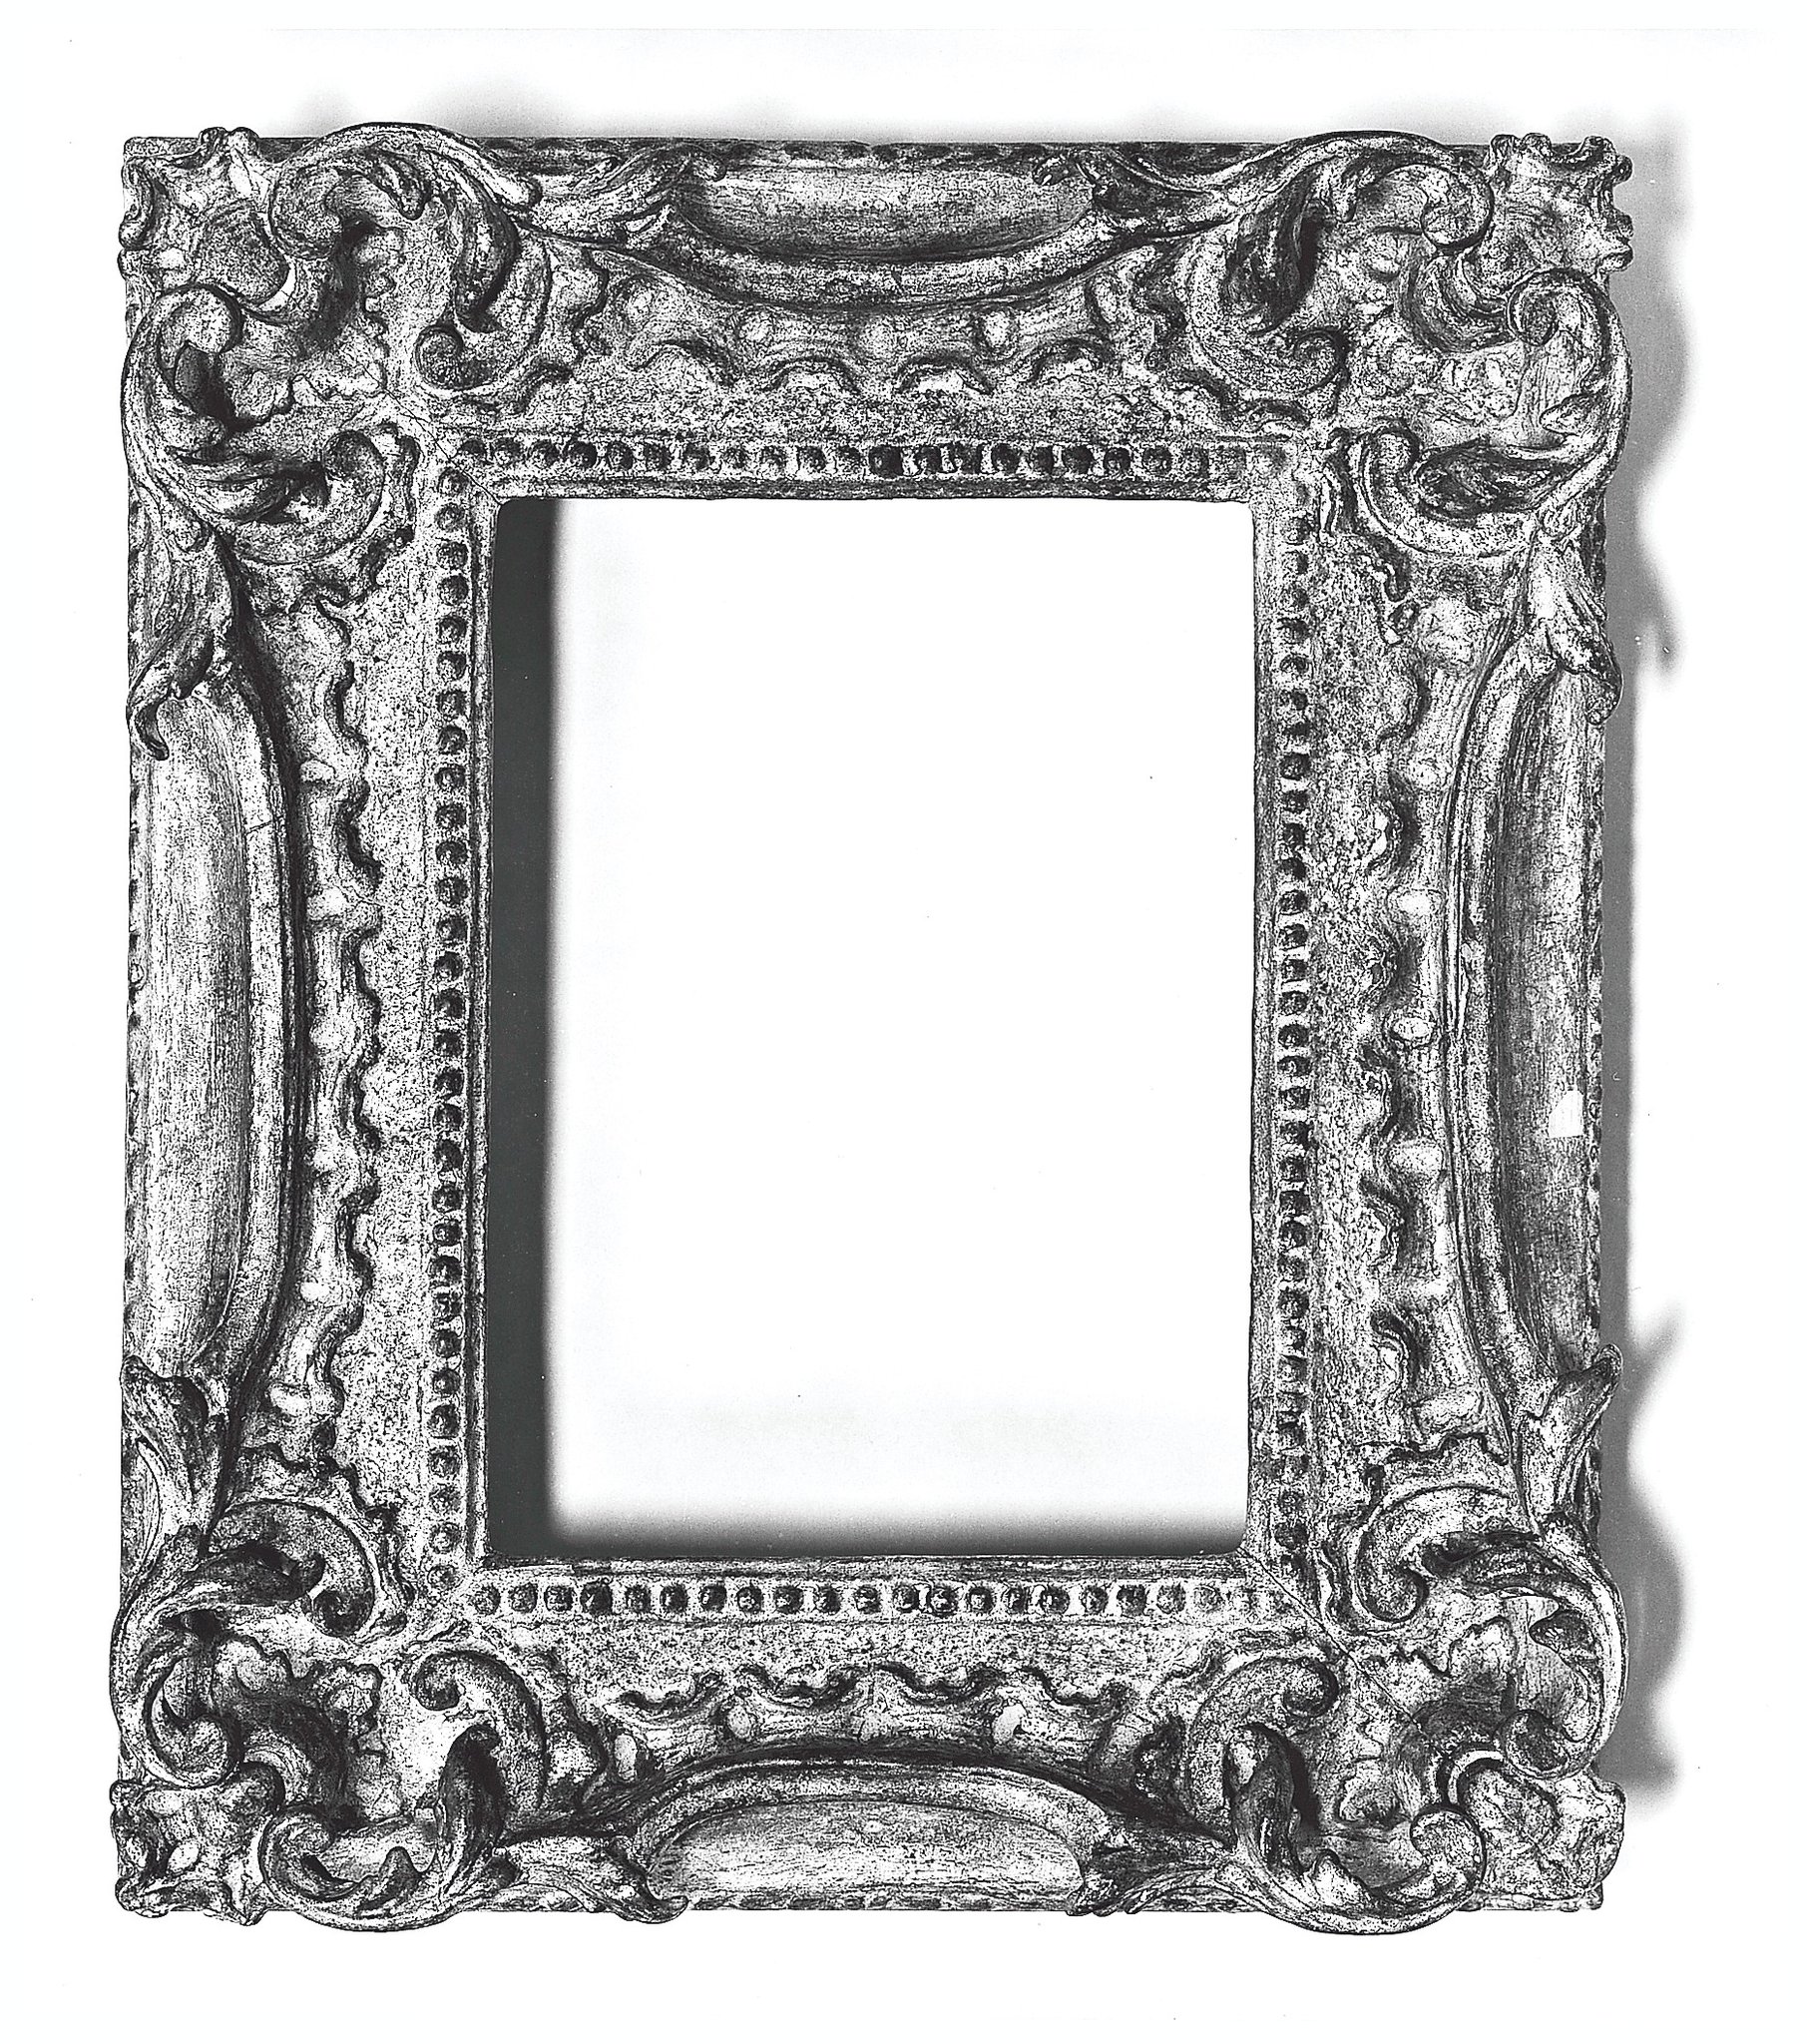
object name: frame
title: Rococo frame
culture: british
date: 1765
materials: wood